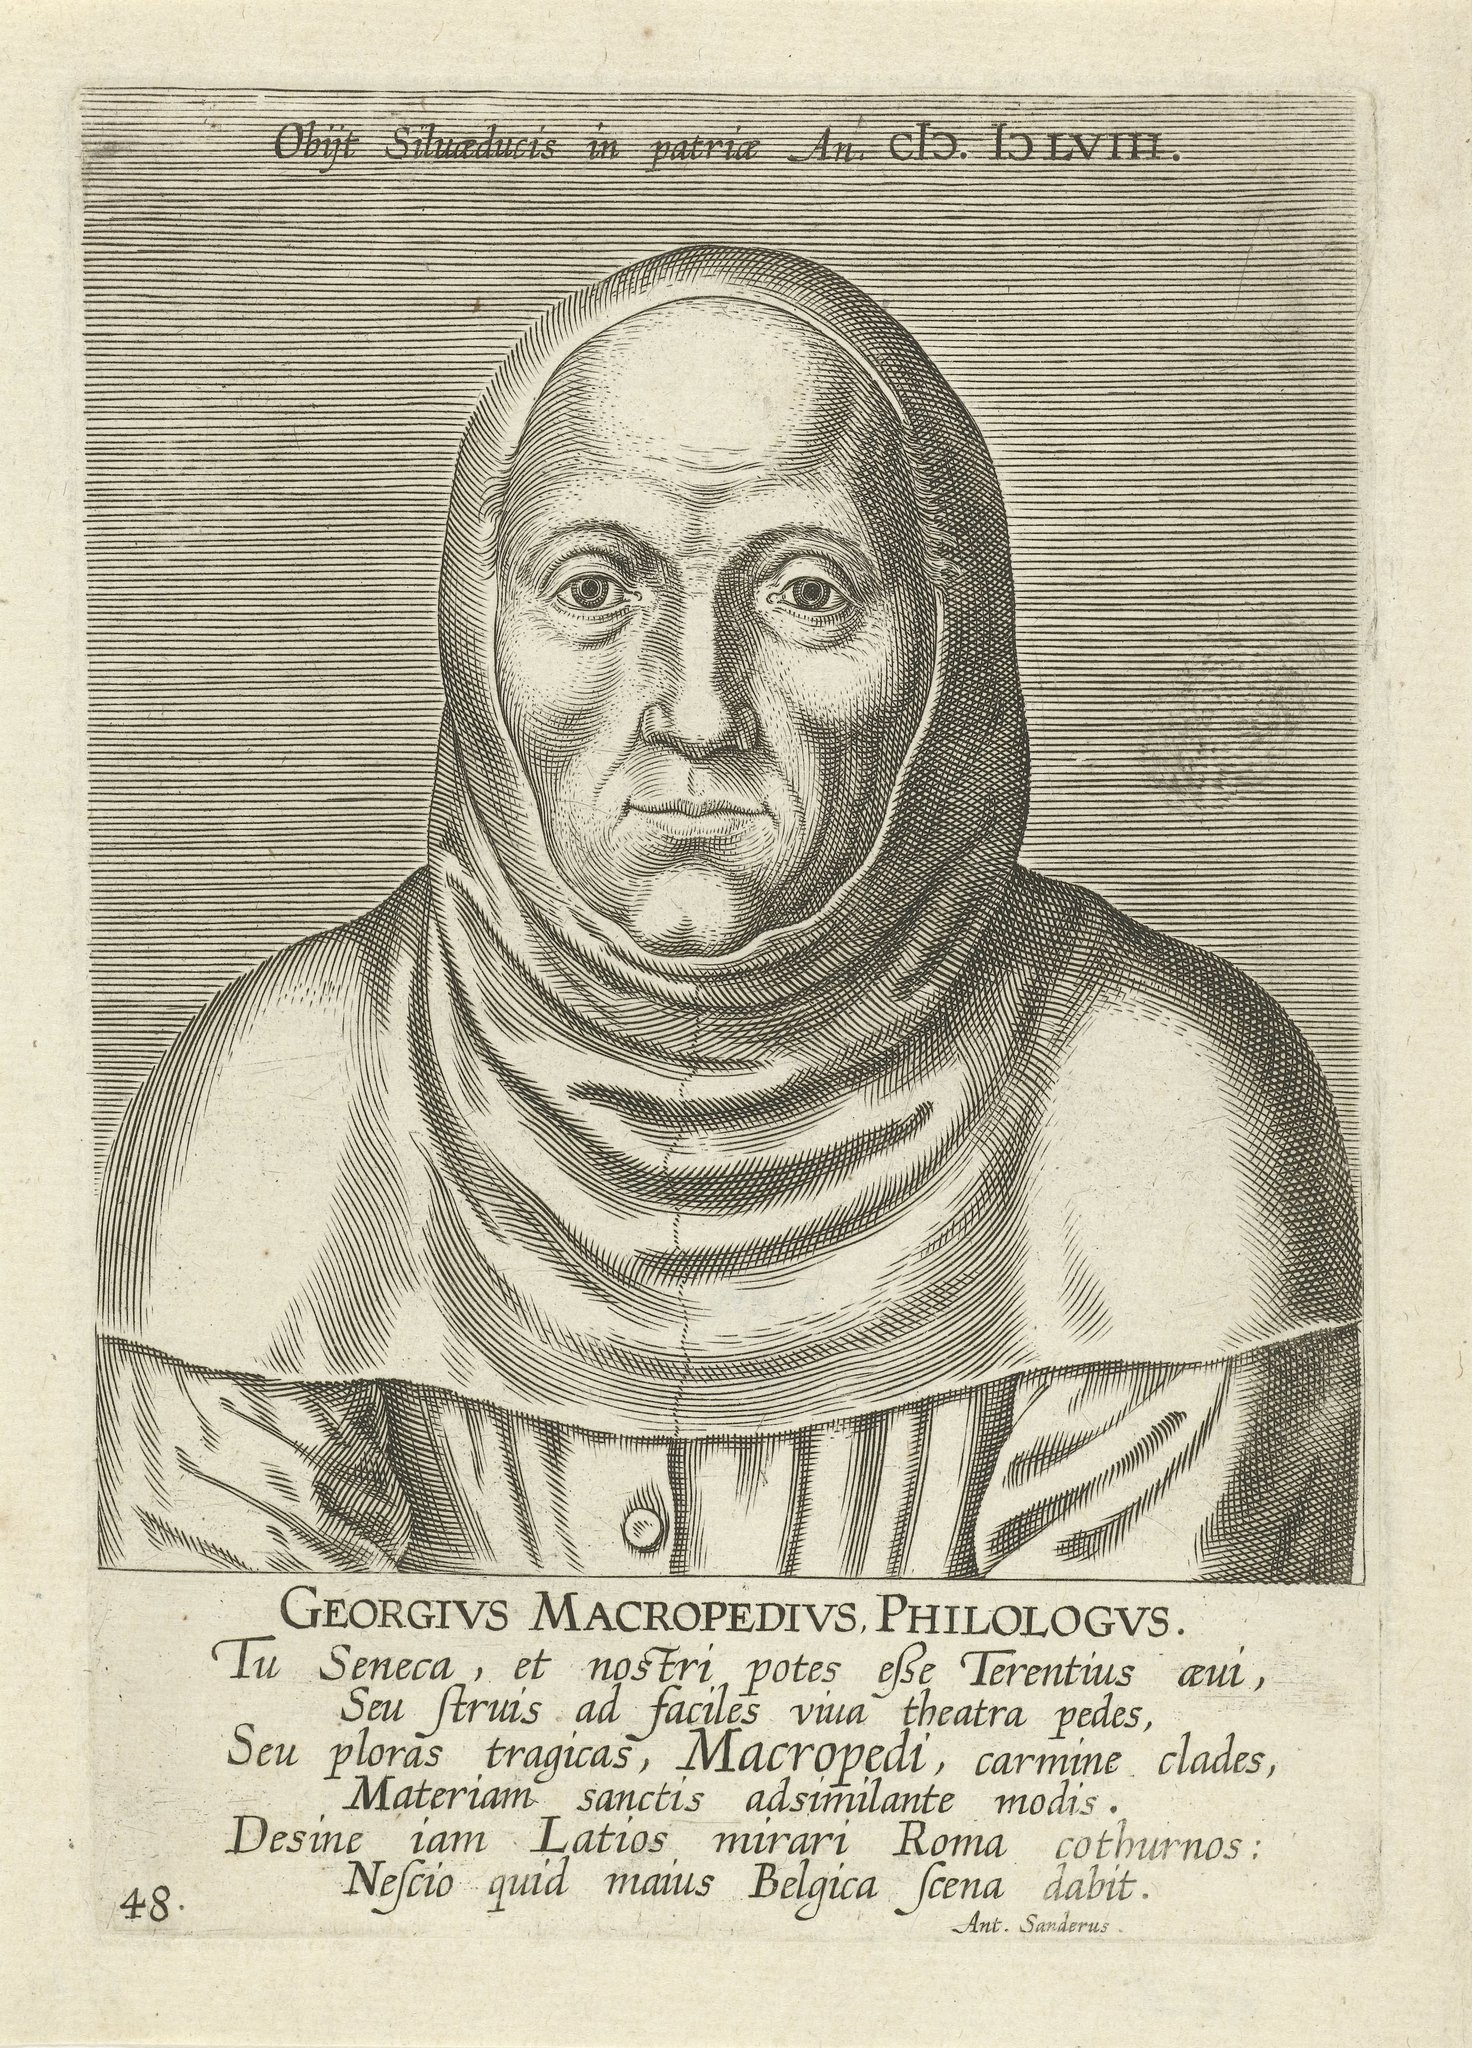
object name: print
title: Georgivs Macropedivs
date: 1604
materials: paper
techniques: engraving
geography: antwerp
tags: gemert, den bosch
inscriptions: collector's mark: Lugt 2228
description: Portret van Georgius Macropedius, Nederlandse geleerde en humanist. Buste naar voor. De prent heeft een Latijns boven- en onderschrift en maakt deel uit van een serie van beroemde Nederlandse en Vlaamse geleerden.